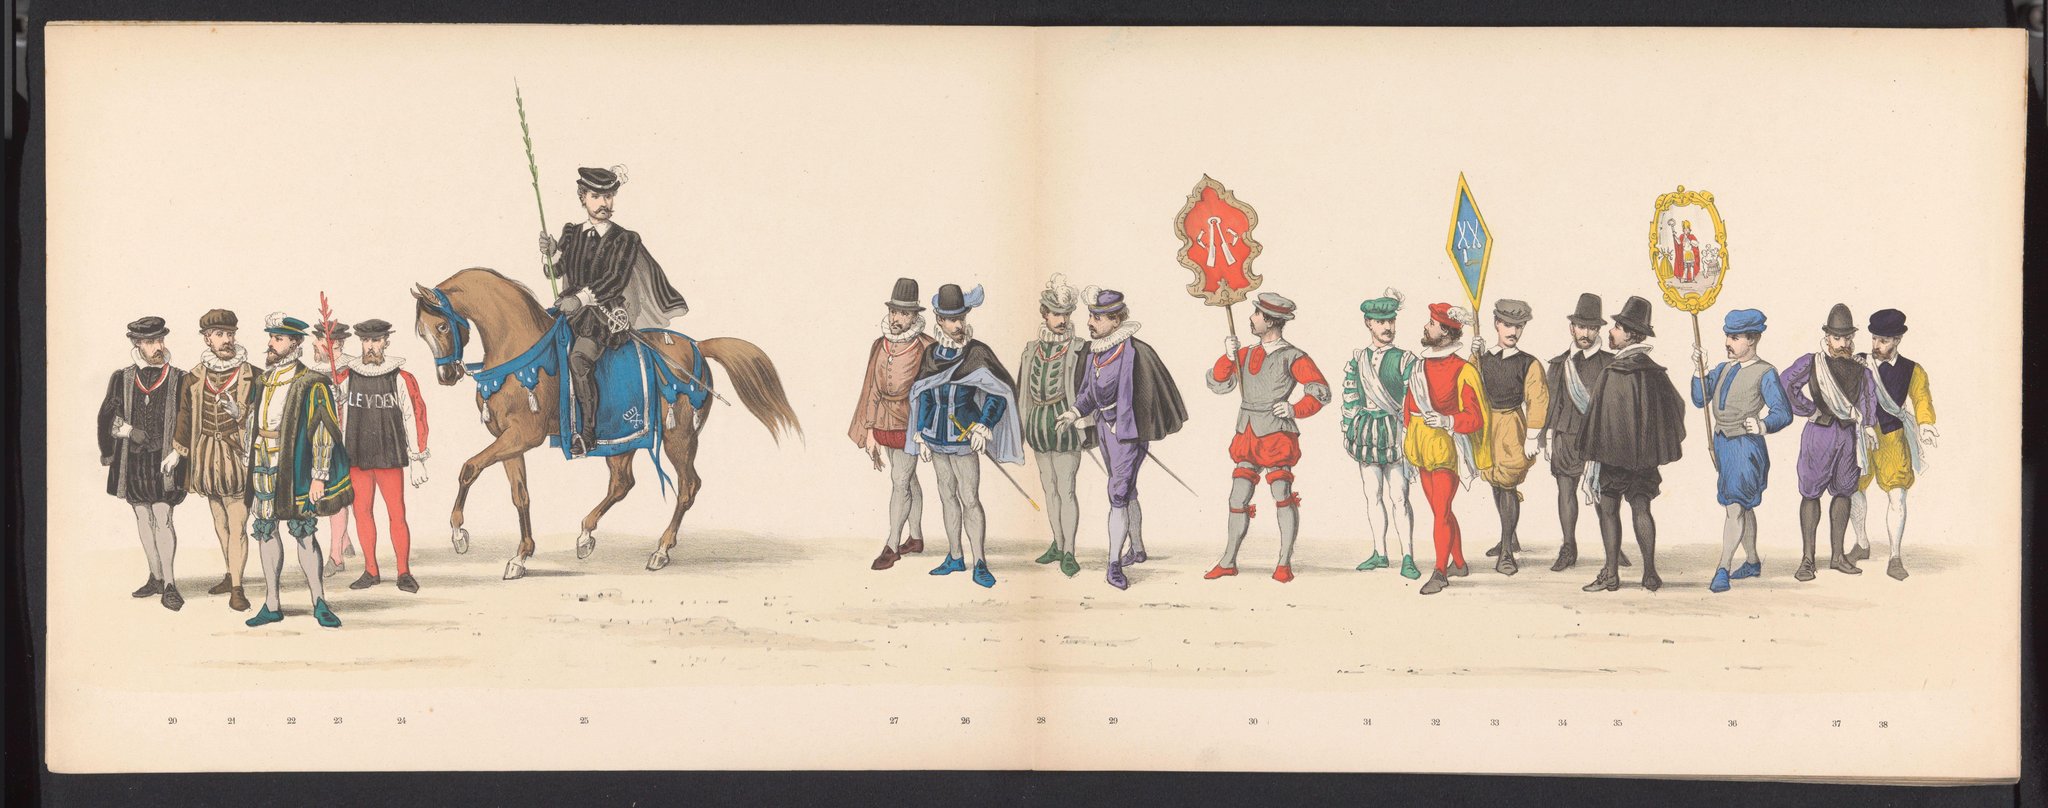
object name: print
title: Maskerade van de Leidse studenten, 1875 (plaat 2)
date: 1875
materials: paper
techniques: hand coloring, lithograph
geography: leiden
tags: students' pageant, costumes used in pageants, leiden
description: Historische gekostumeerde optocht van de studenten van de Leidse Hogeschool gehouden op 15 juni 1875 ter gelegenheid van het 300-jarig bestaan van de Hogeschool. De optocht verbeeldt de beroemdste mannen verbonden aan de Hogeschool. Tweede plaat met de groepen genummerd 20-38. Onderdeel van de serie van 21 aaneen geplakte bladen.